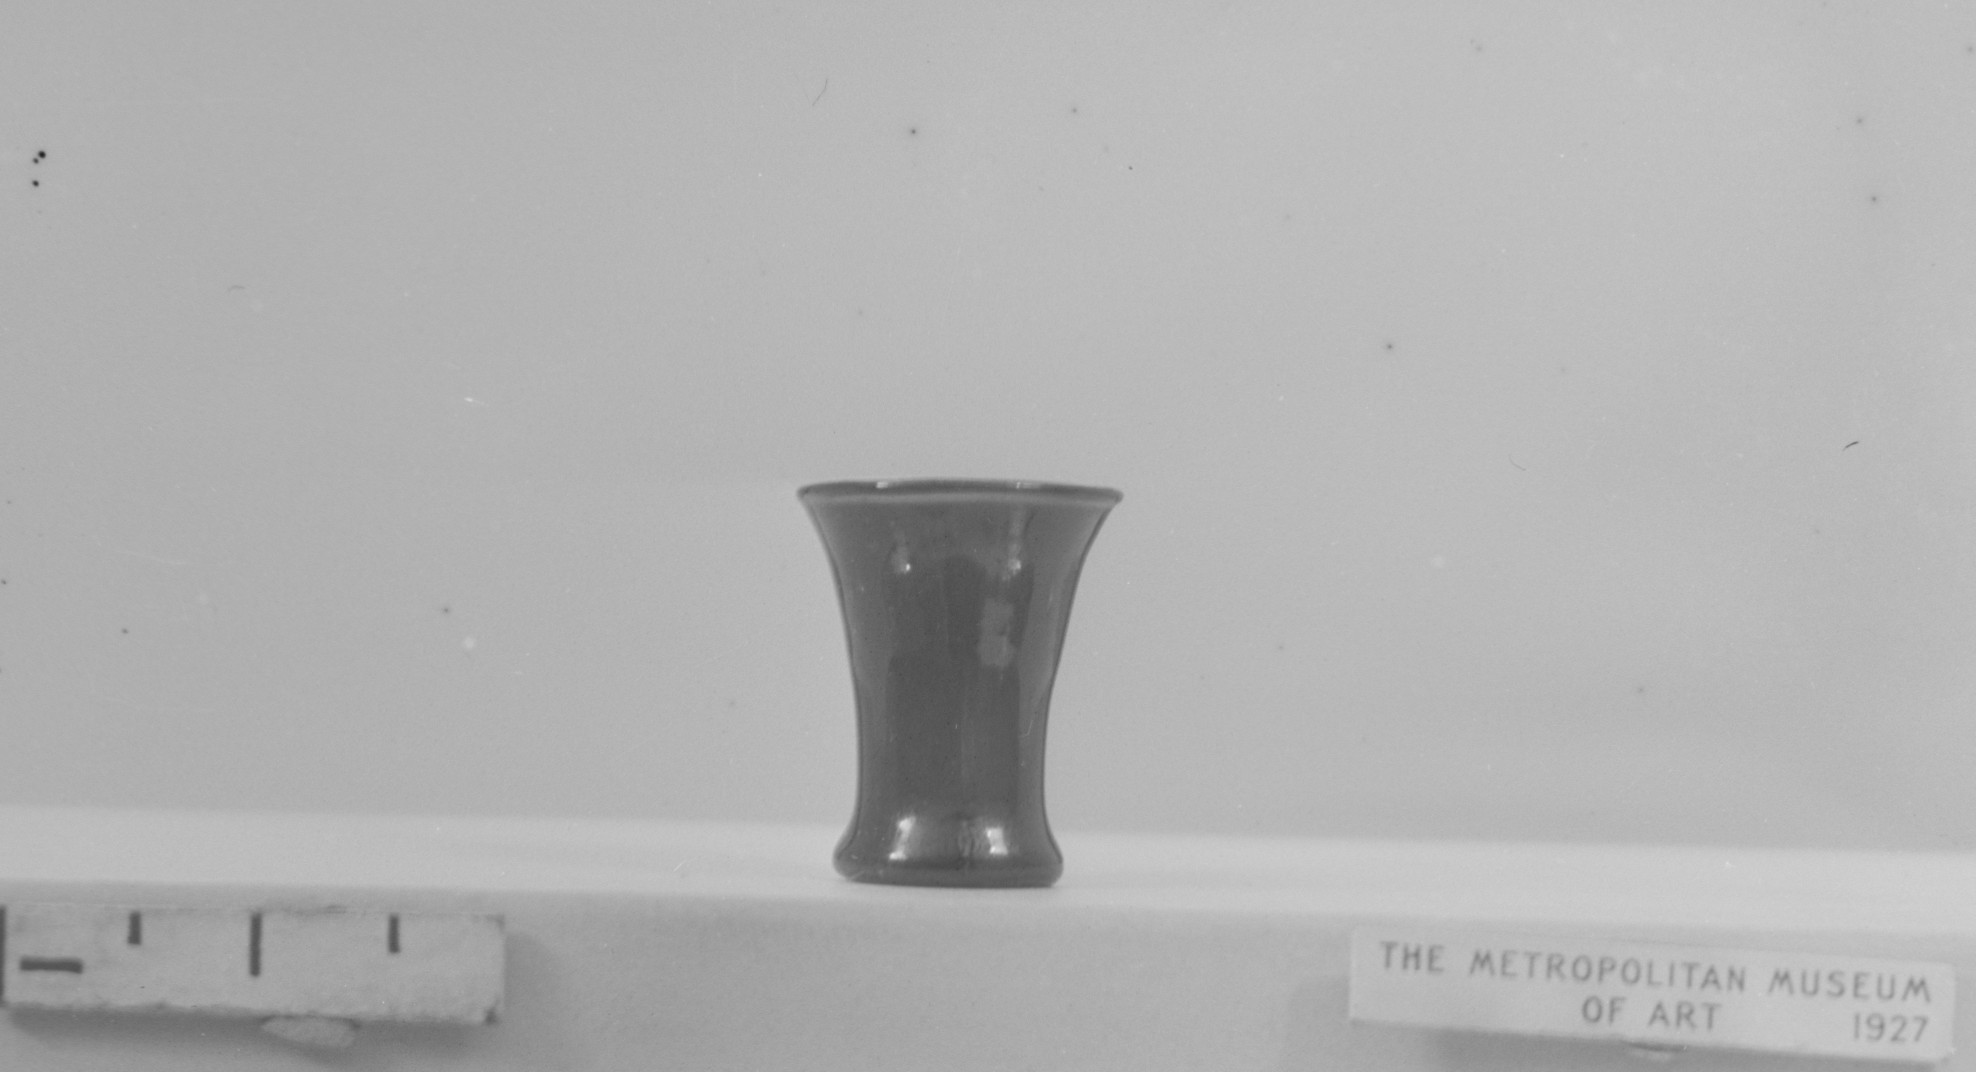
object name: beaker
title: Miniature beaker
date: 1801-1833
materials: glass